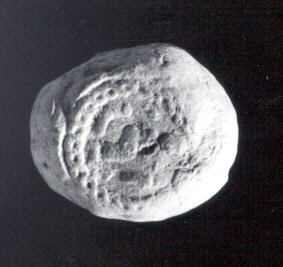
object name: stamp seal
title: Oval sealing with one circular seal impression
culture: assyrian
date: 1800-1701 BCE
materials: clay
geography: anatolia